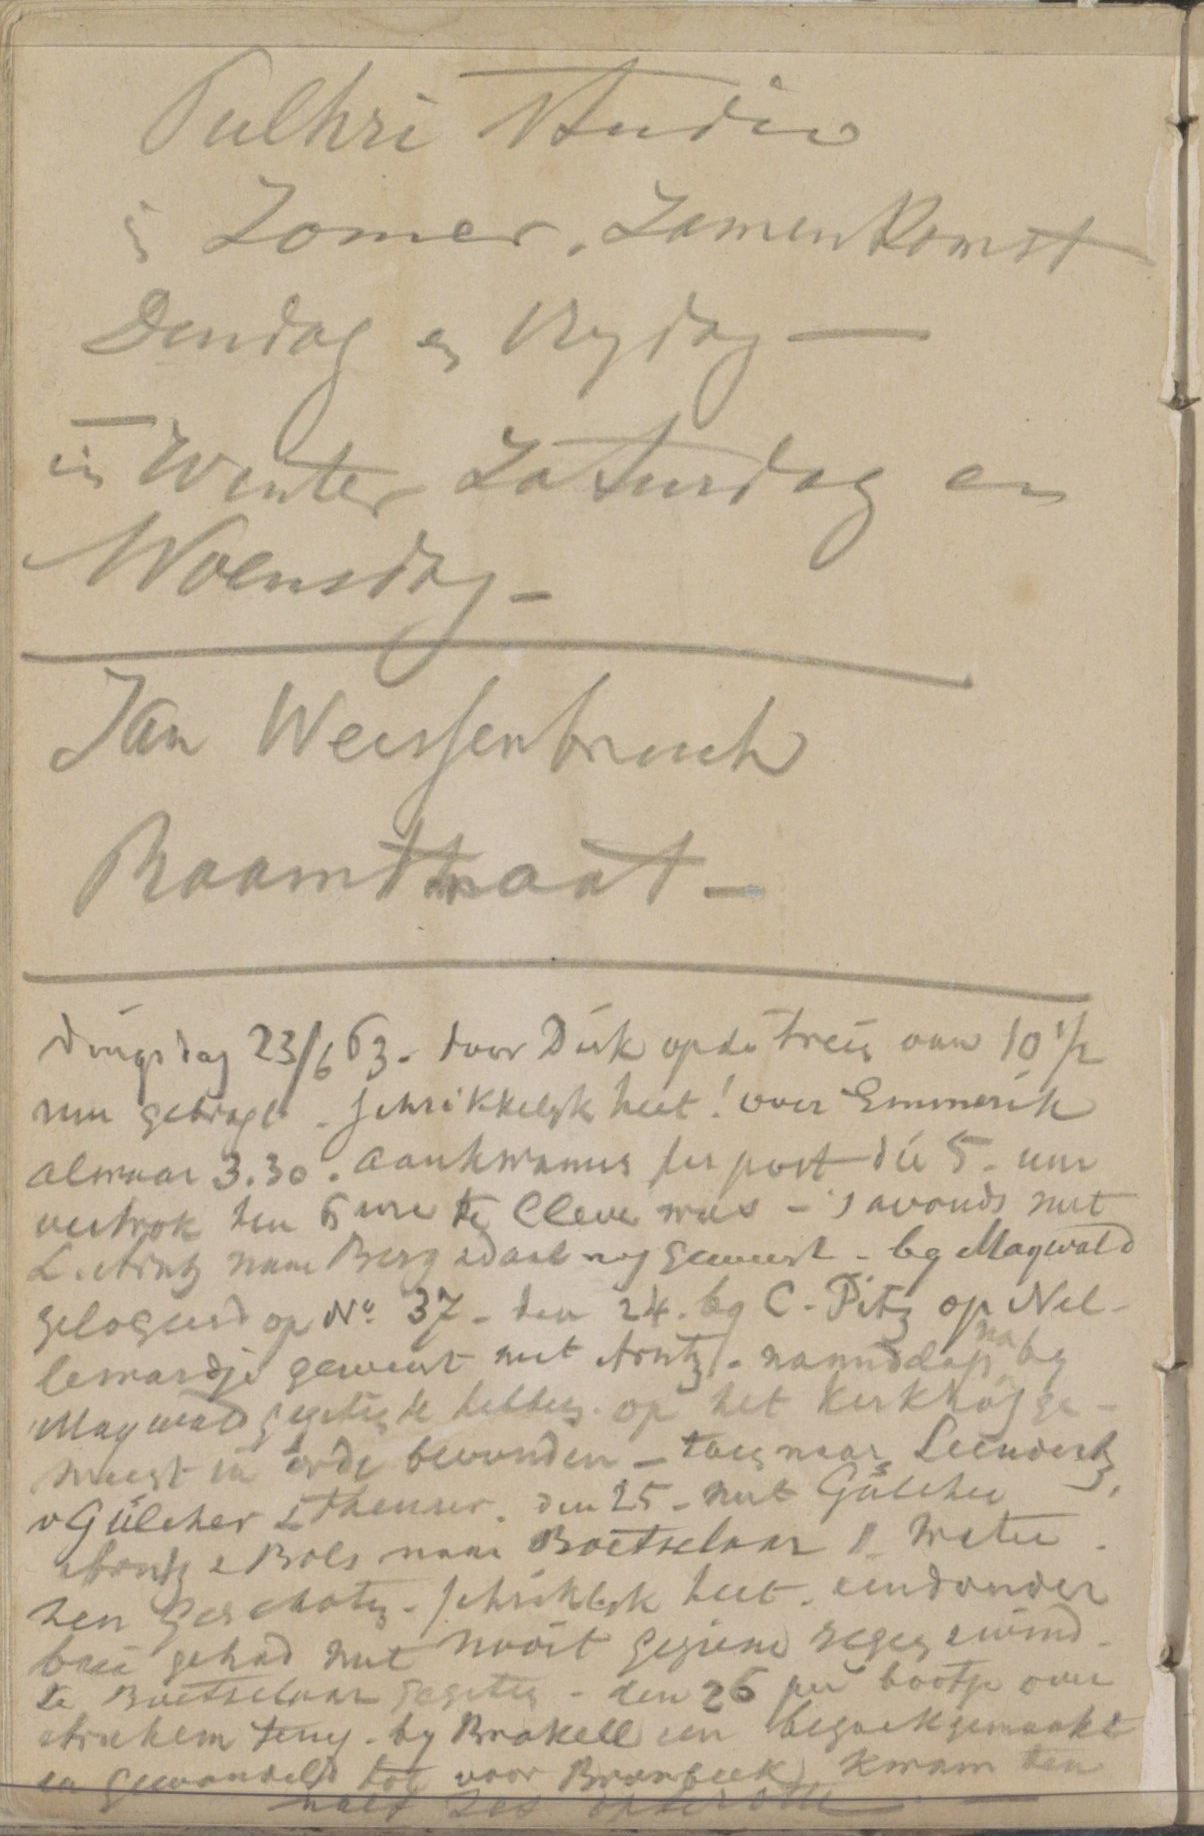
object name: sketchbook leaf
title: Notities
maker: johannes tavenraat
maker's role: draughtsman, painter, print maker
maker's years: 1809-1881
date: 1806-1863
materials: paper, pencil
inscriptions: annotation: ‘[...]’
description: Blad 39 verso uit een schetsboek met 65 bladen.